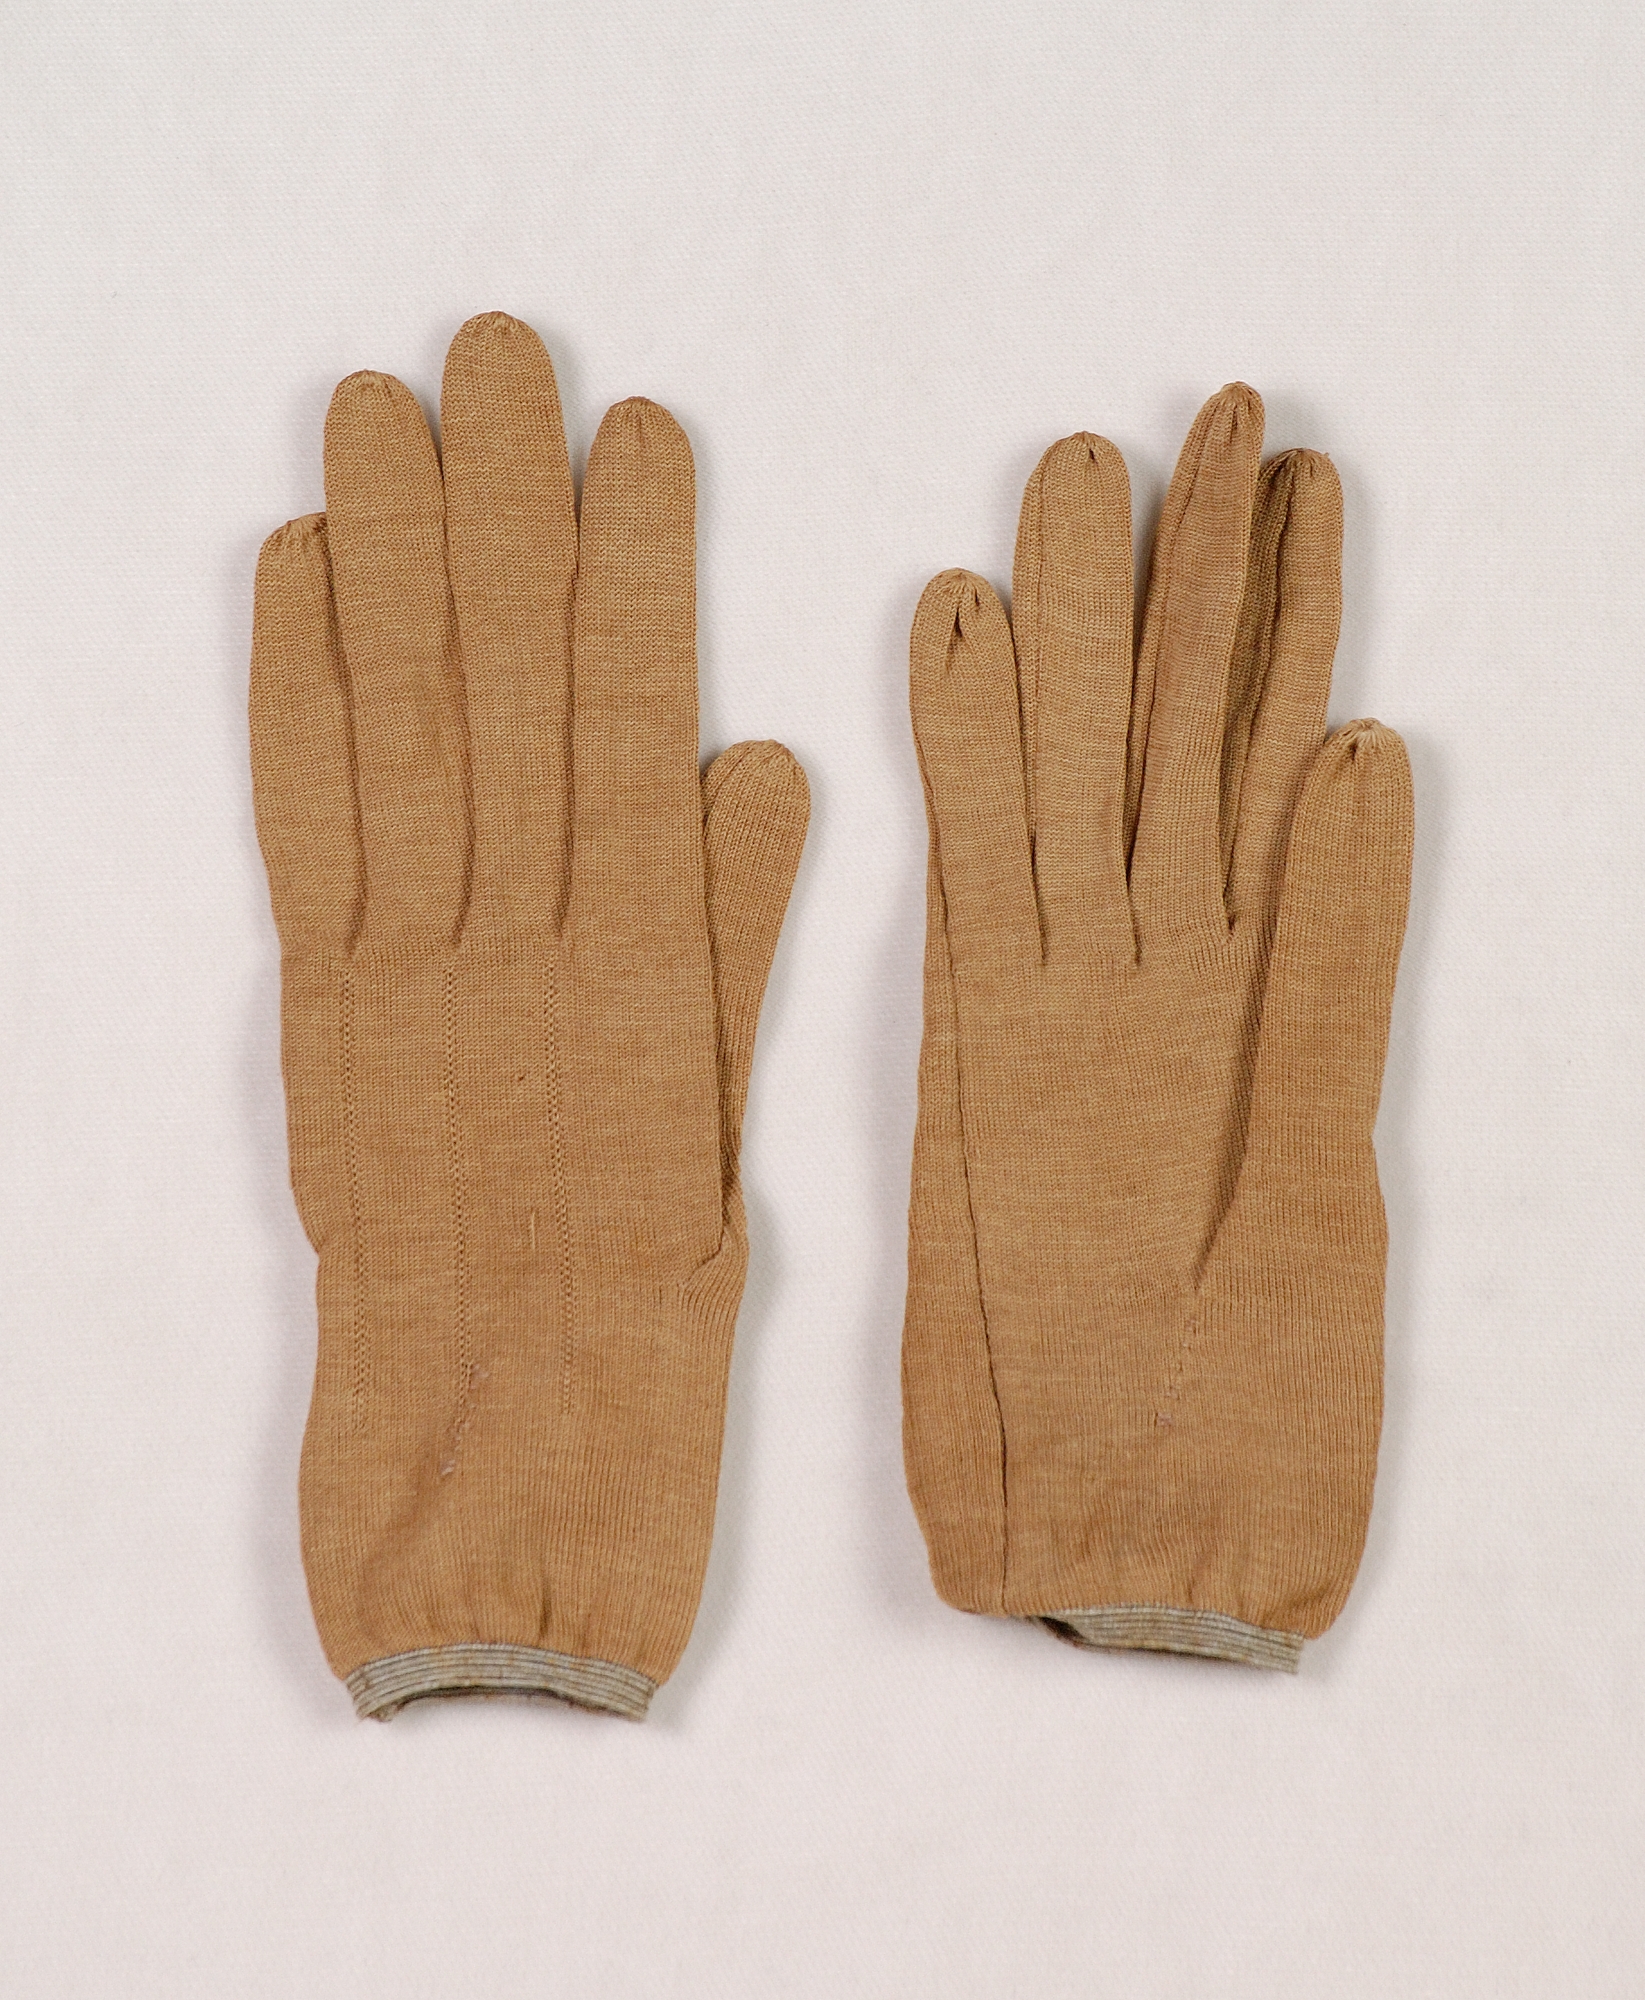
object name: glove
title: Gloves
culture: american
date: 1851-1875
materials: cotton